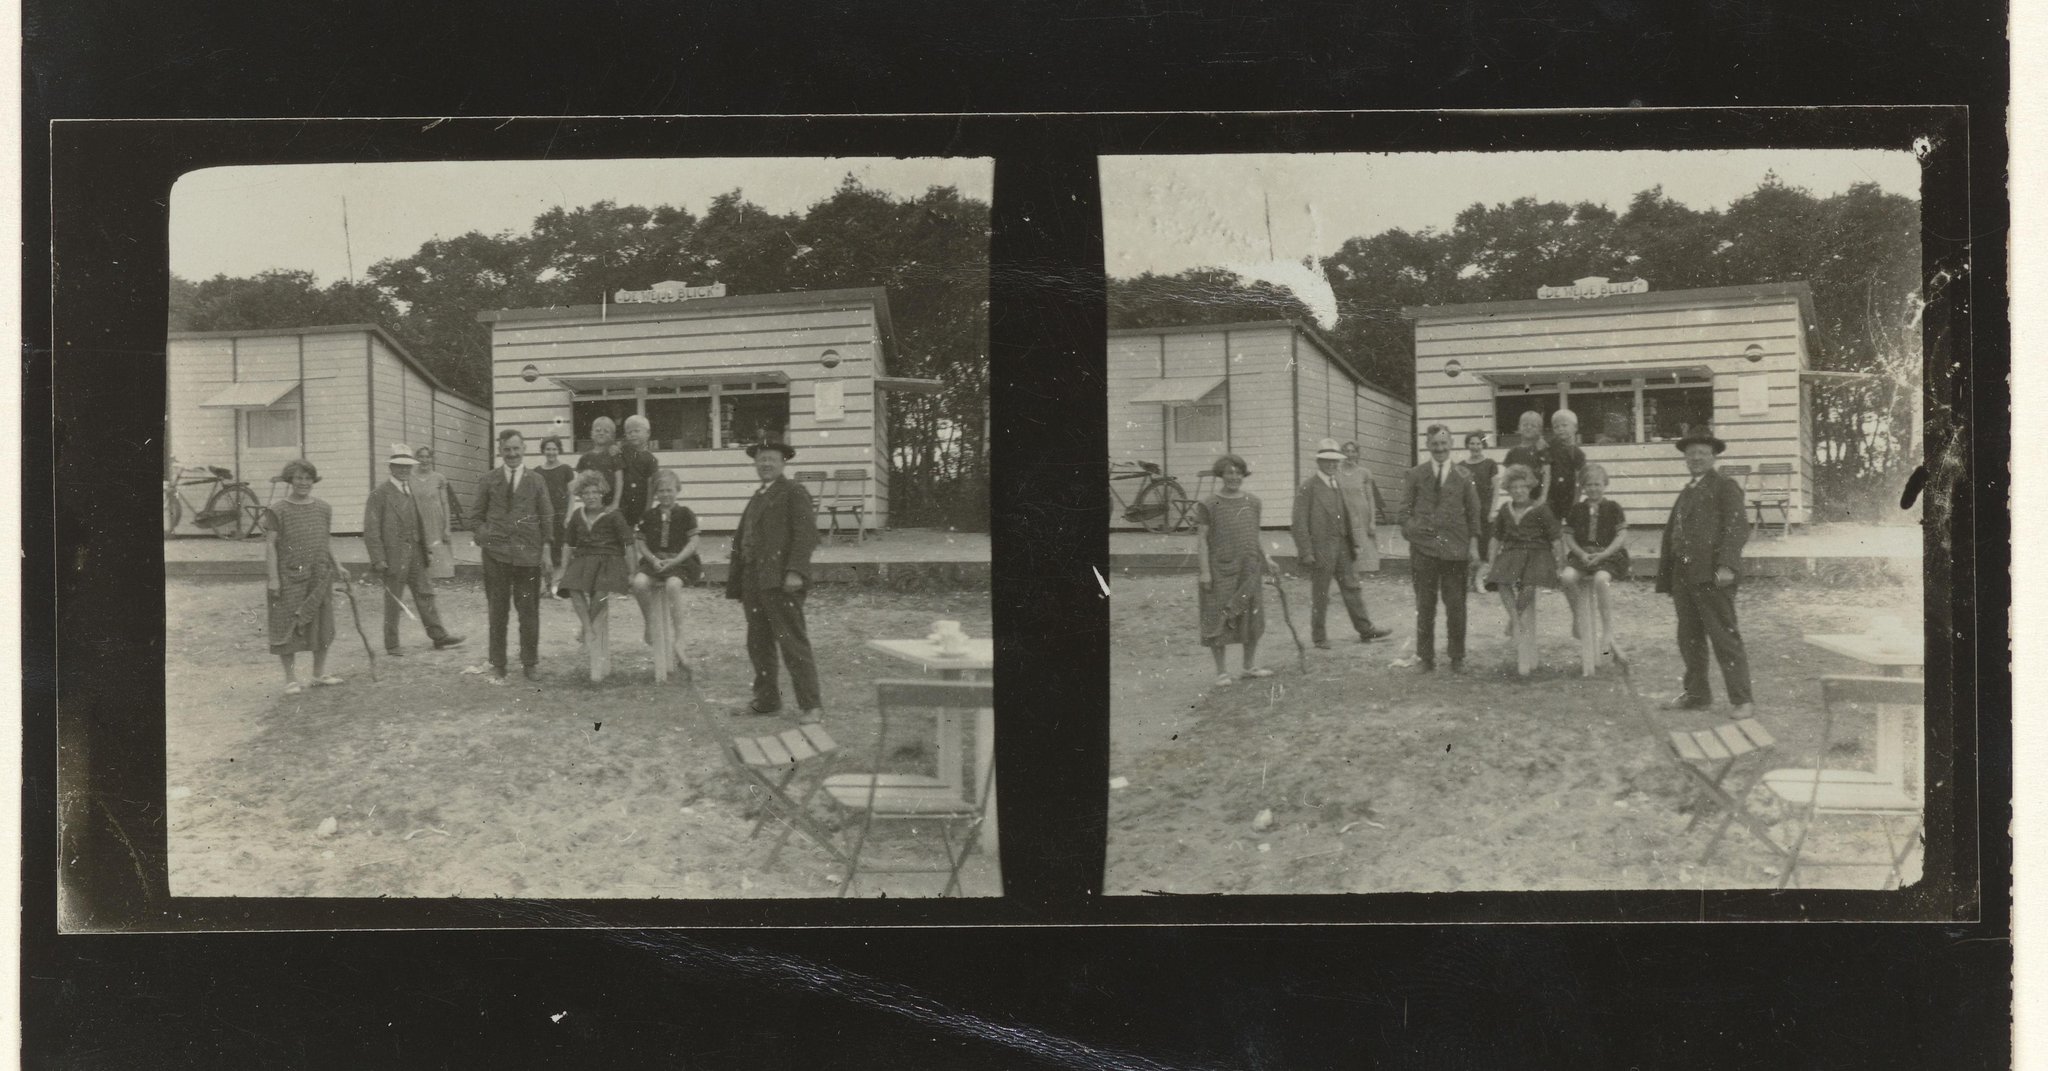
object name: stereograph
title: Gezicht op De Weije Blick op het strand van Valkeveen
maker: Anonymous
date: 1925-1950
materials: paper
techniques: gelatin silver print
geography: valkeveen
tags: beach (as place of recreation)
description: De Weije Blick, tweemaal afgedrukt op één kaart. Op de voorgrond poseert een groep mensen. De Weije Blick was de naam van het bedrijf van de grootvader van de schenkster.